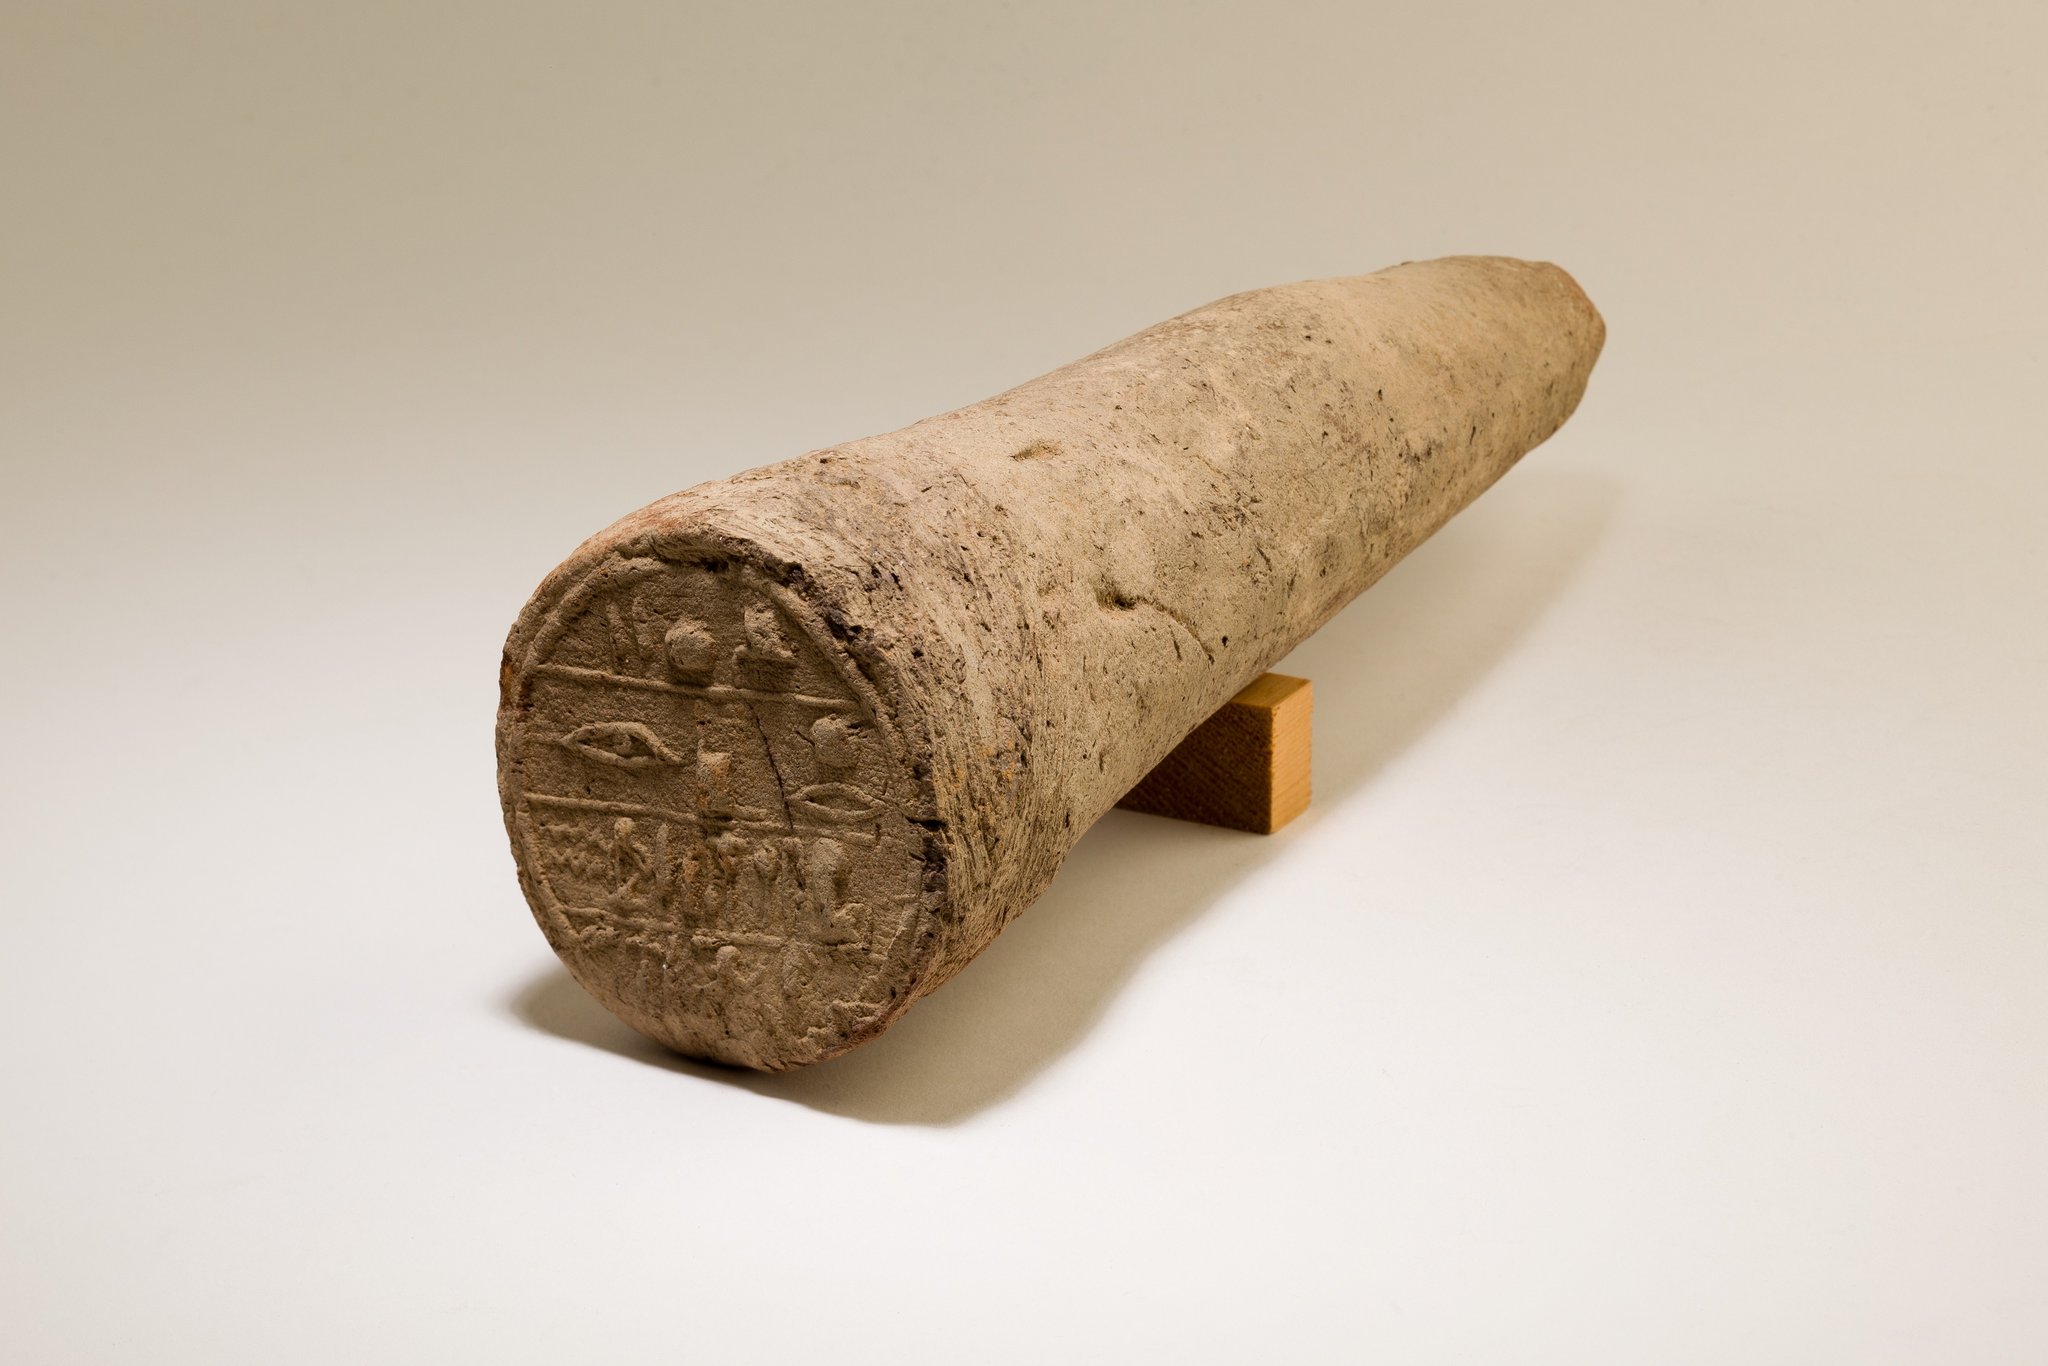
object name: cone, curcular impression, ineni, inspector of scribe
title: Funerary Cone of the Inspector of Scribes Ineni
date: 1550-1295 BCE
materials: pottery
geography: egypt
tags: hieroglyphs